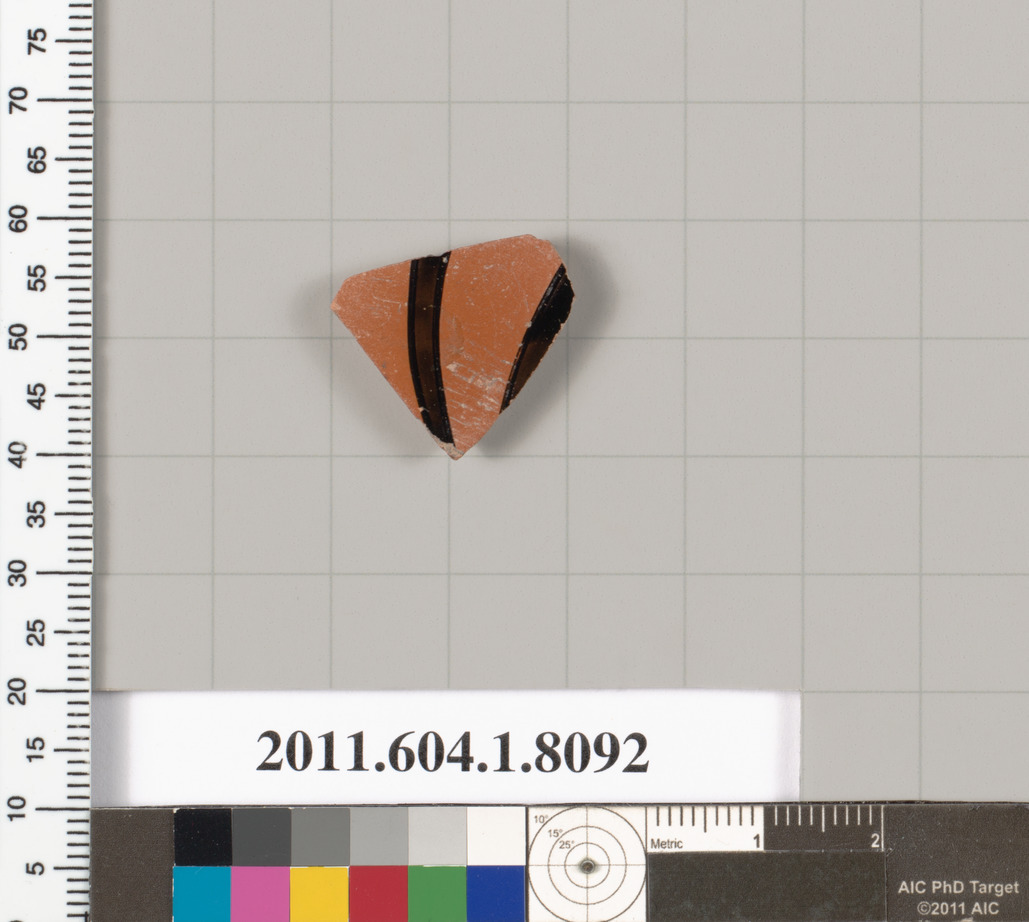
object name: kylix fragment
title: Terracotta fragment of a kylix (drinking cup)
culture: greek, attic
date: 510-500 BCE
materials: terracotta